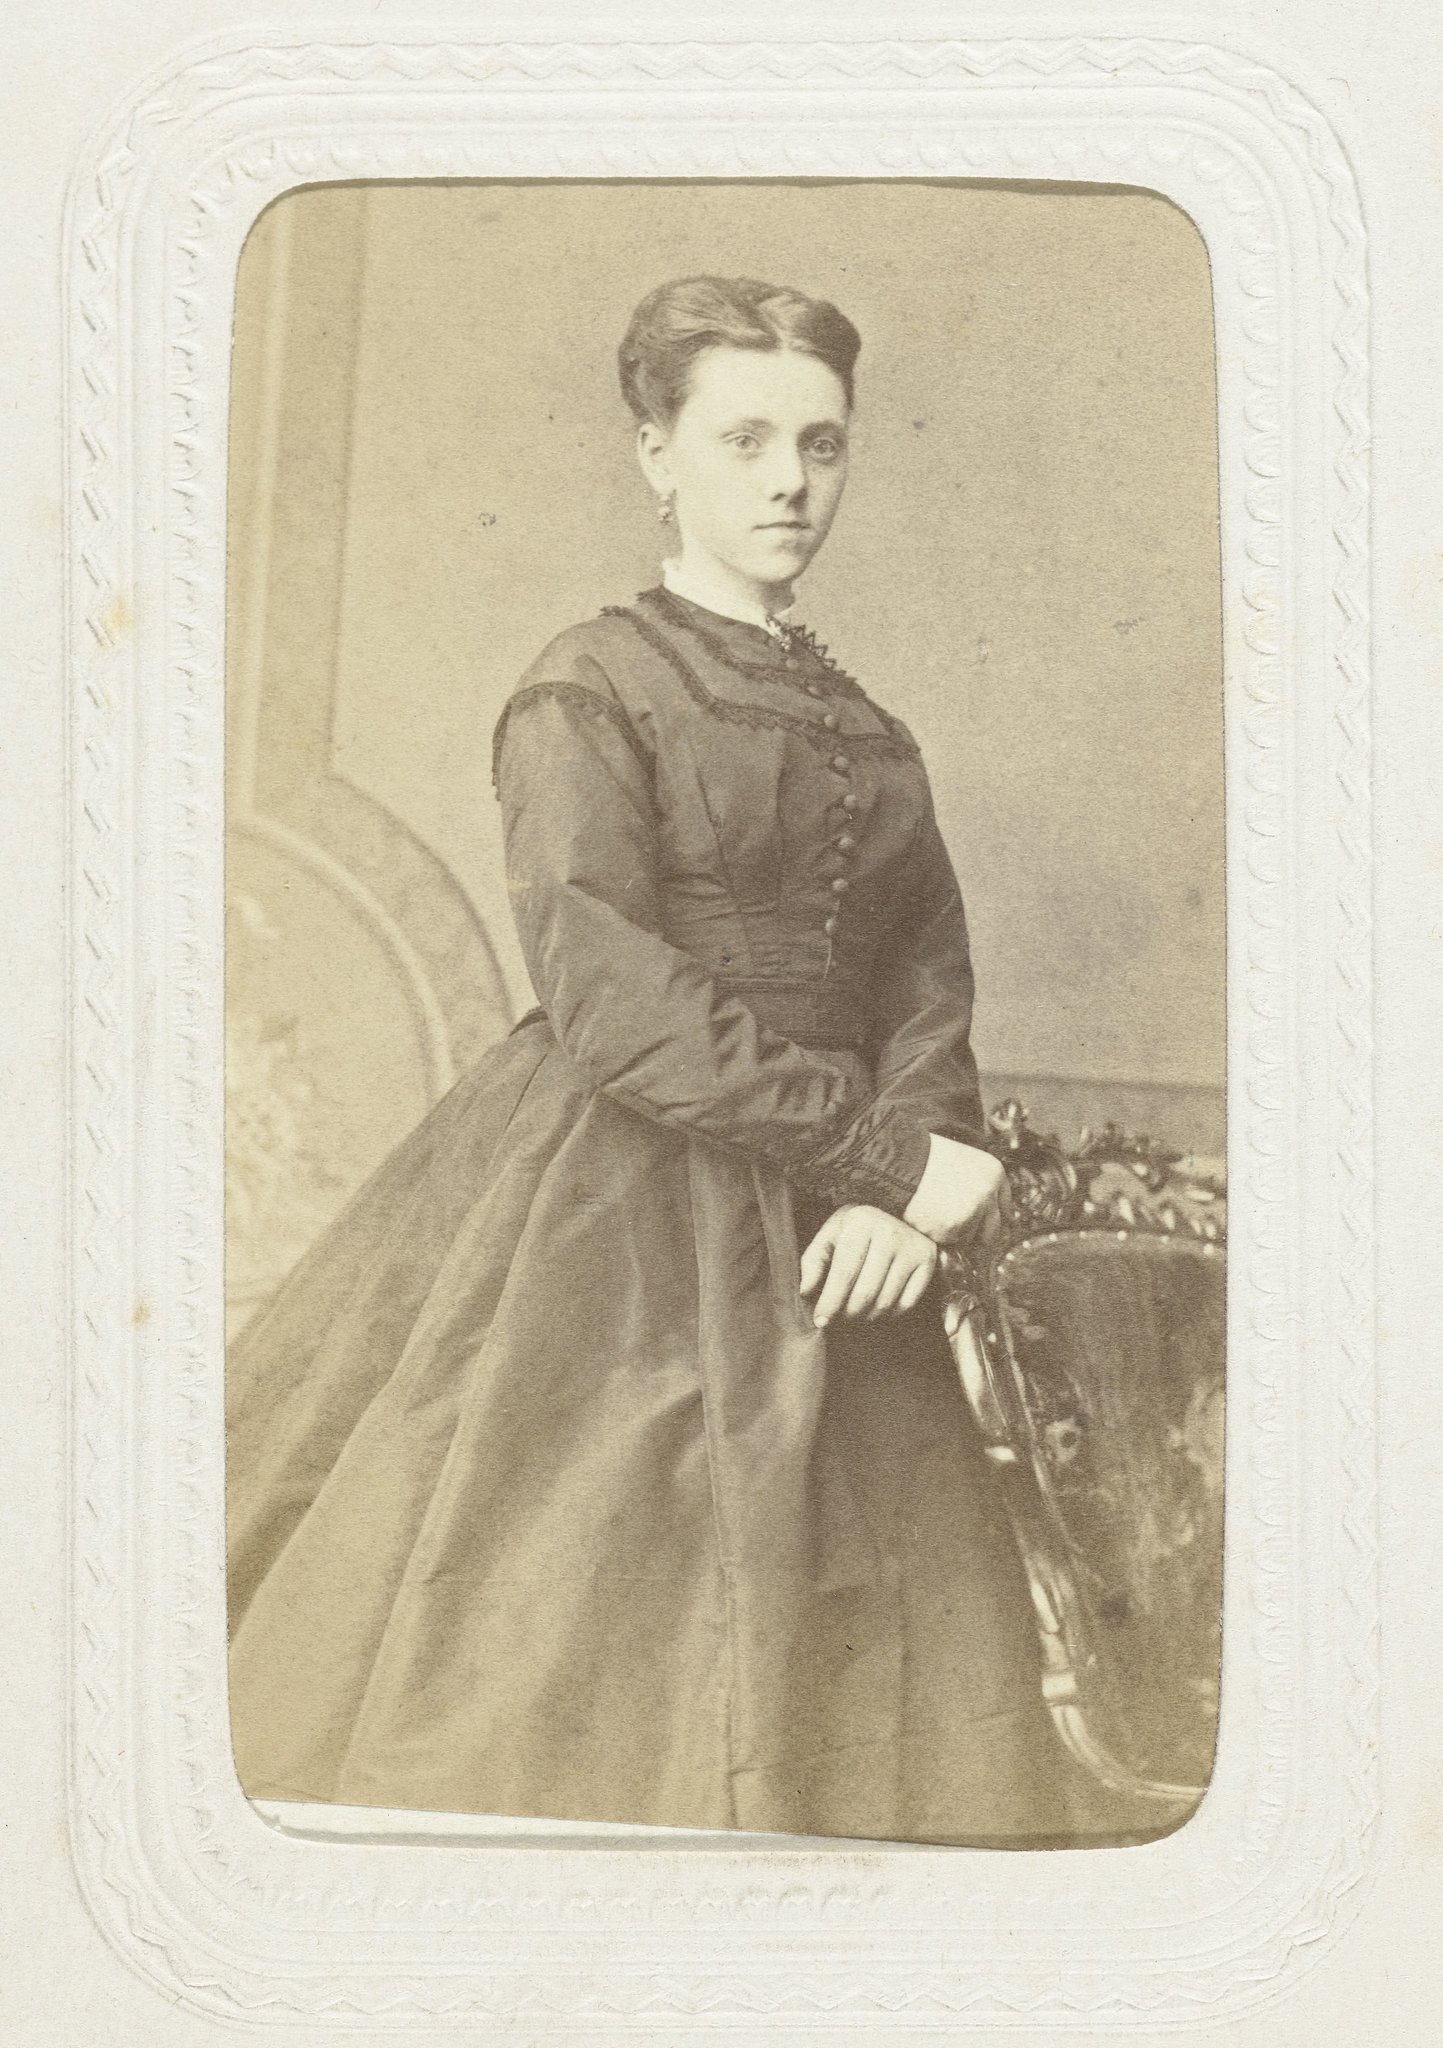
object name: carte de visite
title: Studioportret van een jonge vrouw in een lange zwarte jurk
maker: carel eduard westerborg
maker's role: fotograaf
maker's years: 1842-1916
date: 1863-1866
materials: cardboard, paper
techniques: albumen print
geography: arnhem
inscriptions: name: ‘Westerborg, Arnhem’